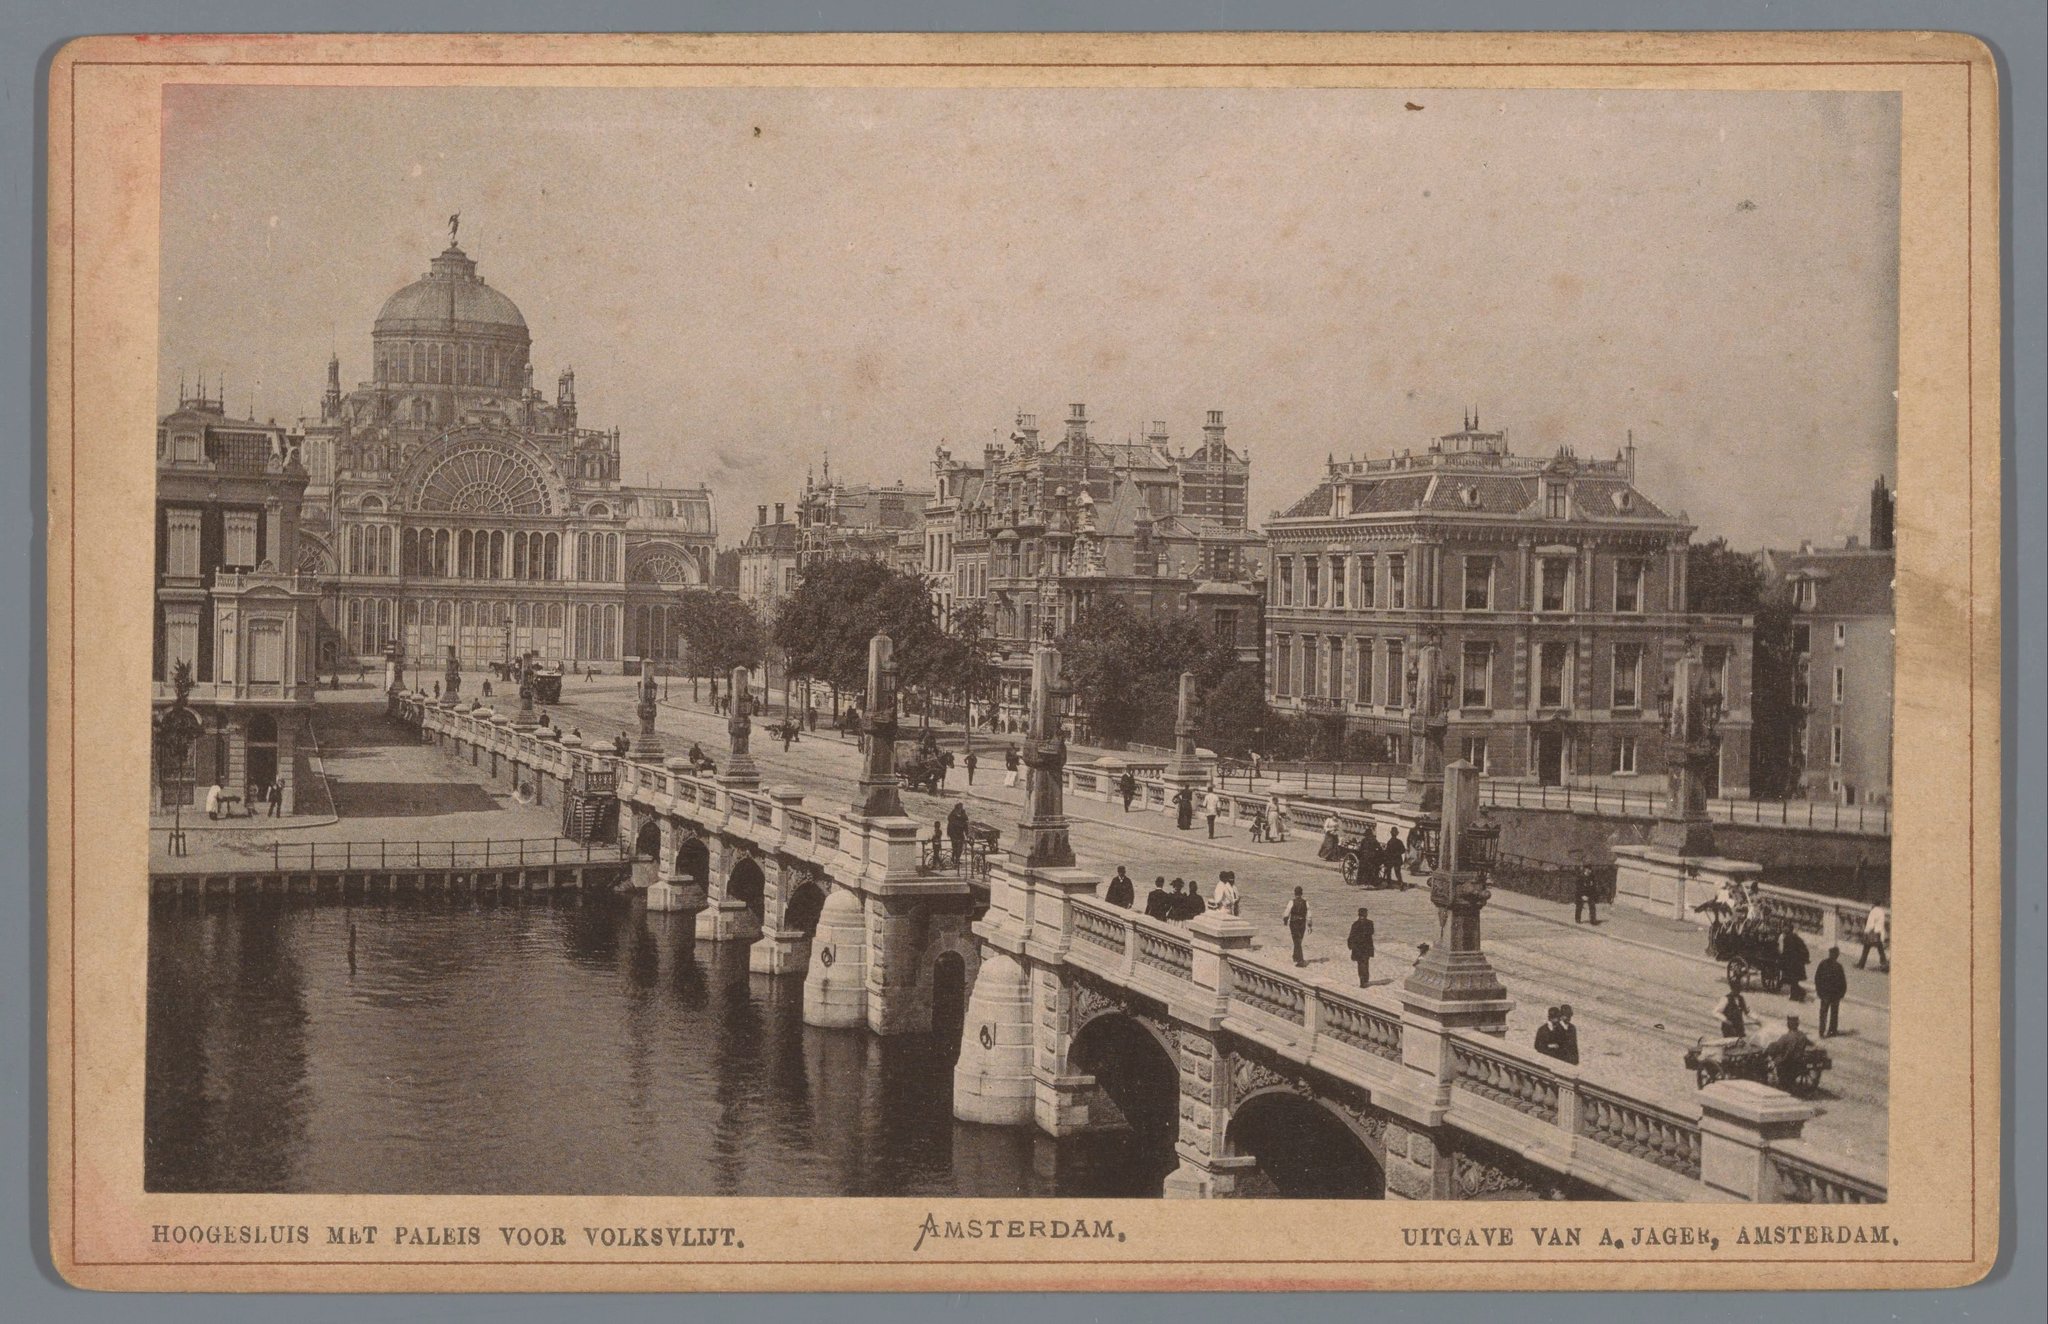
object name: photomechanical print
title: Hoogesluis met Paleis voor Volksvlijt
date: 1860-1890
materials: cardboard, paper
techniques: photograph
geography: amsterdam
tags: palace, canals, waters (in city)